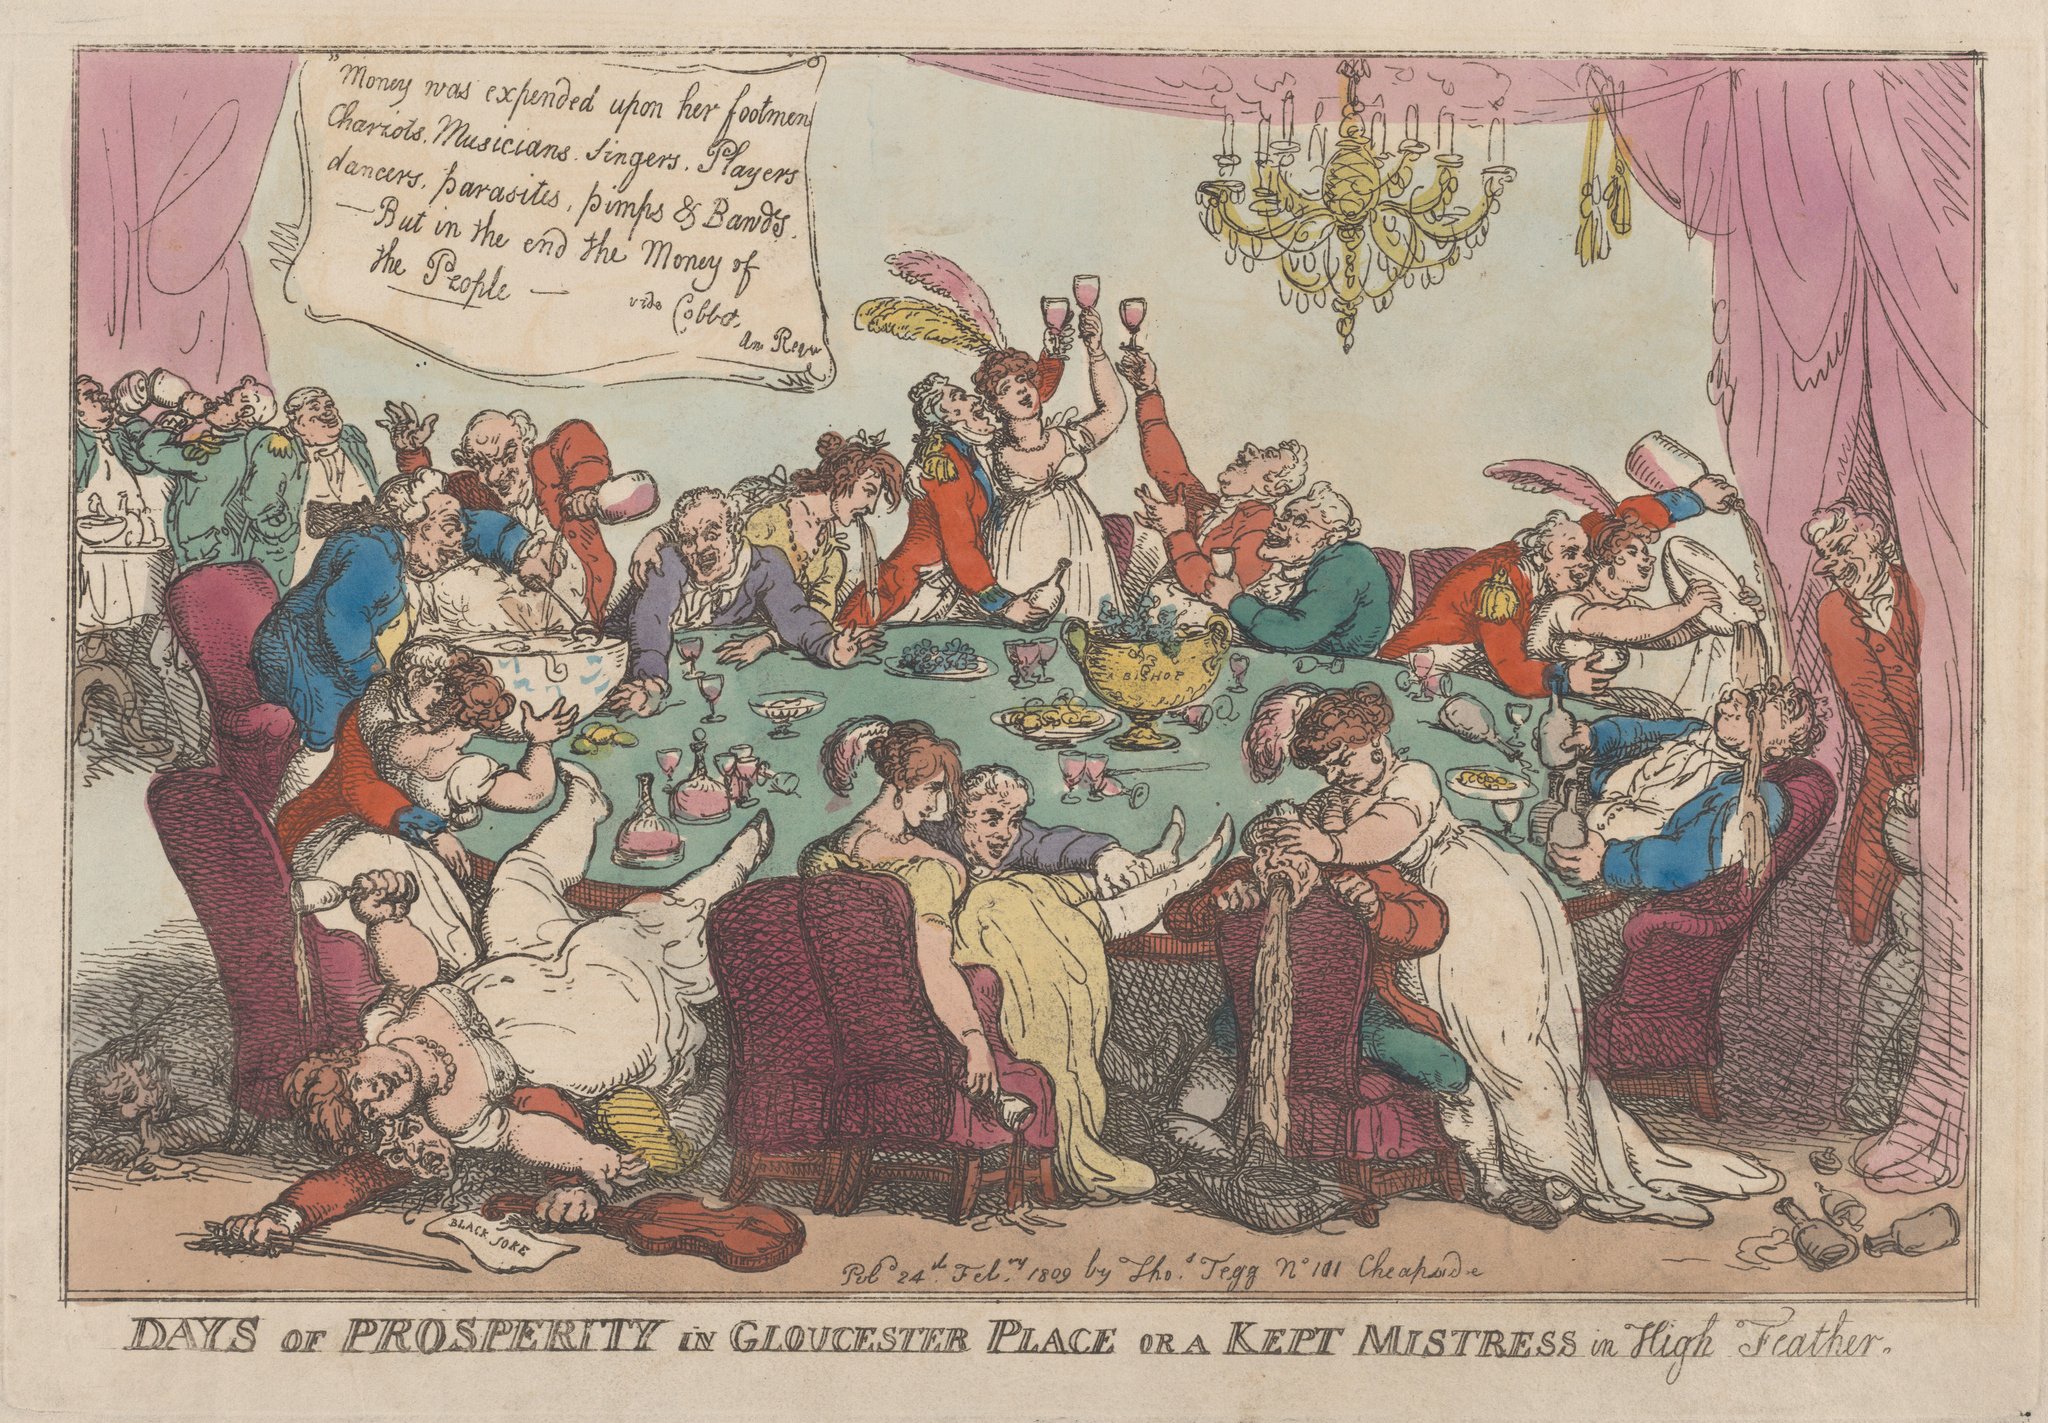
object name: print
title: Days of Prosperity in Gloucester Place or a Kept Mistress in High Feather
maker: thomas rowlandson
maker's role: artist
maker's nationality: british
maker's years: 1757-1827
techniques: etching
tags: satire,men,women,party,drinking,politics